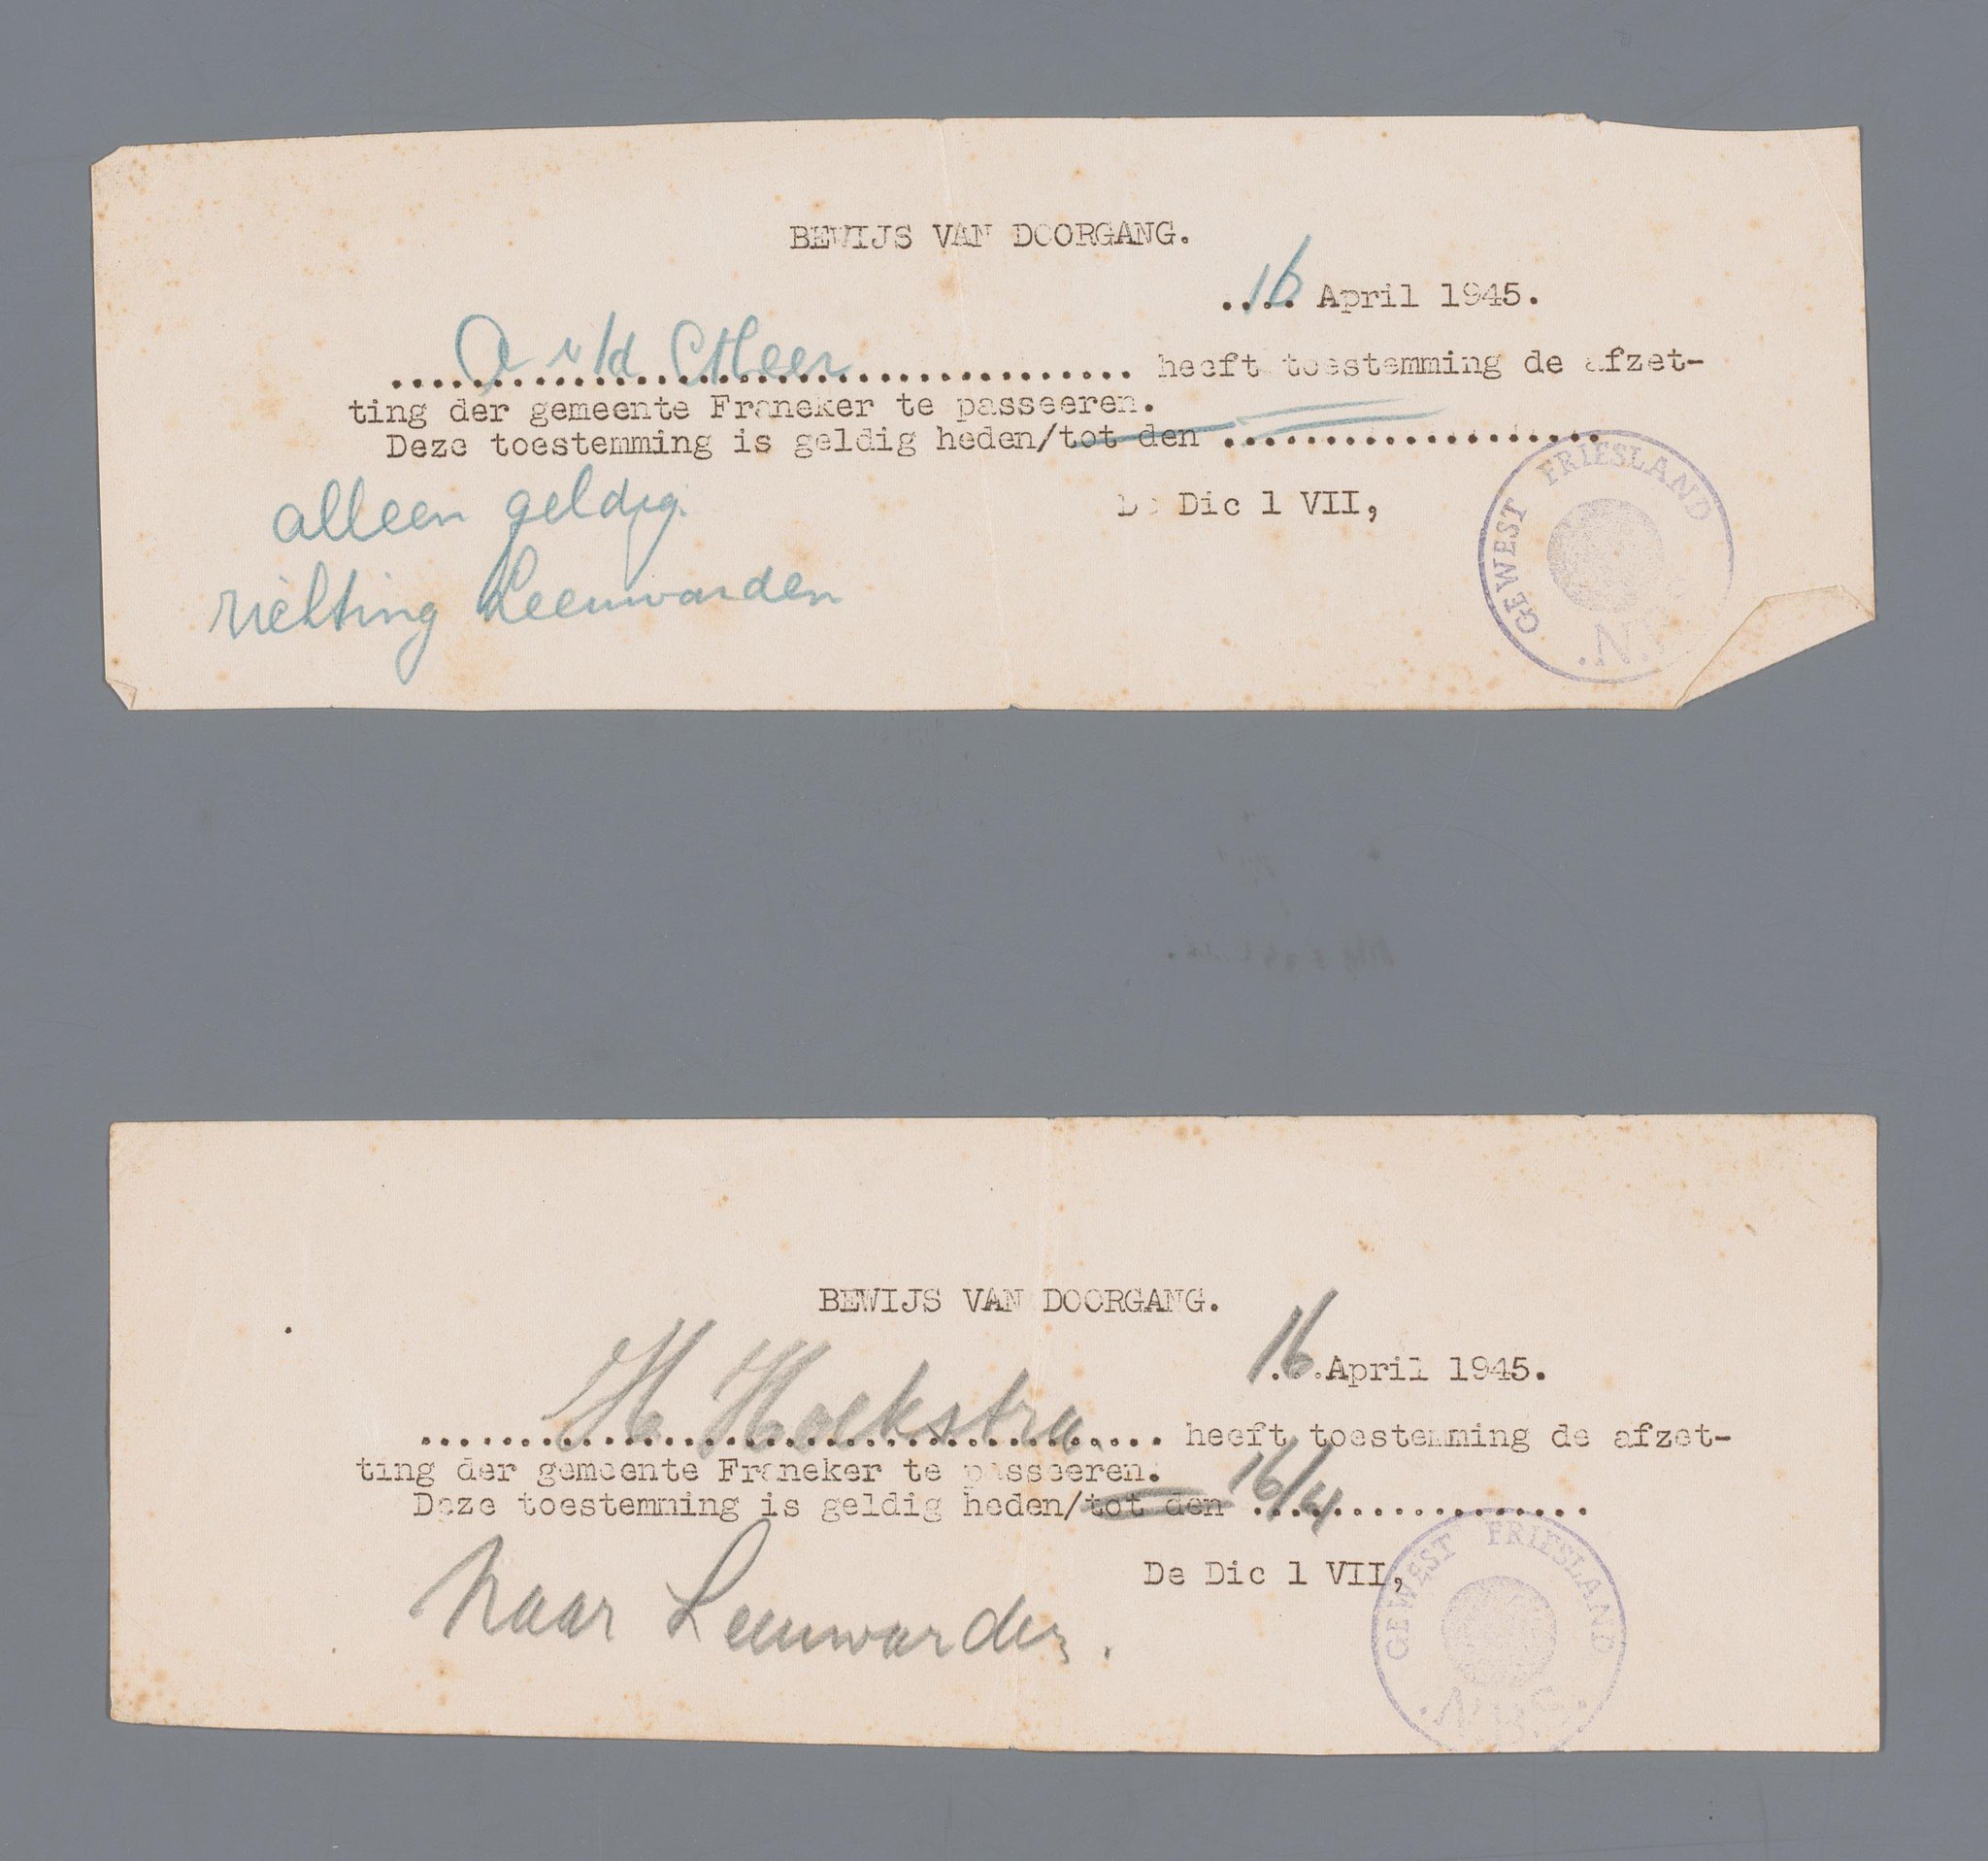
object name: bewijs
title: Document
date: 1945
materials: paper, pencil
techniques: mimeography, writing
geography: franeker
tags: netherlands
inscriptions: date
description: Document, bewijs van doorgang. Langwerpig, met potlood ingevuld stencil, waarin H. Hoekstra toestemming wordt verleend Franeker in de richting van Leeuwarden te verlaten. Gemerkt; stempel: 'N.B.S. Gewest Friesland'.